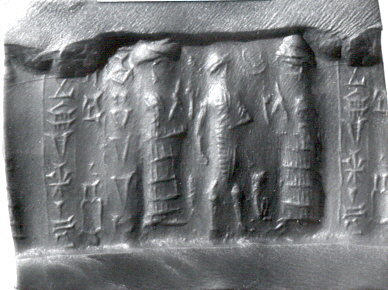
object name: cylinder seal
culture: babylonian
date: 1900-1501 BCE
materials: mineral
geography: mesopotamia